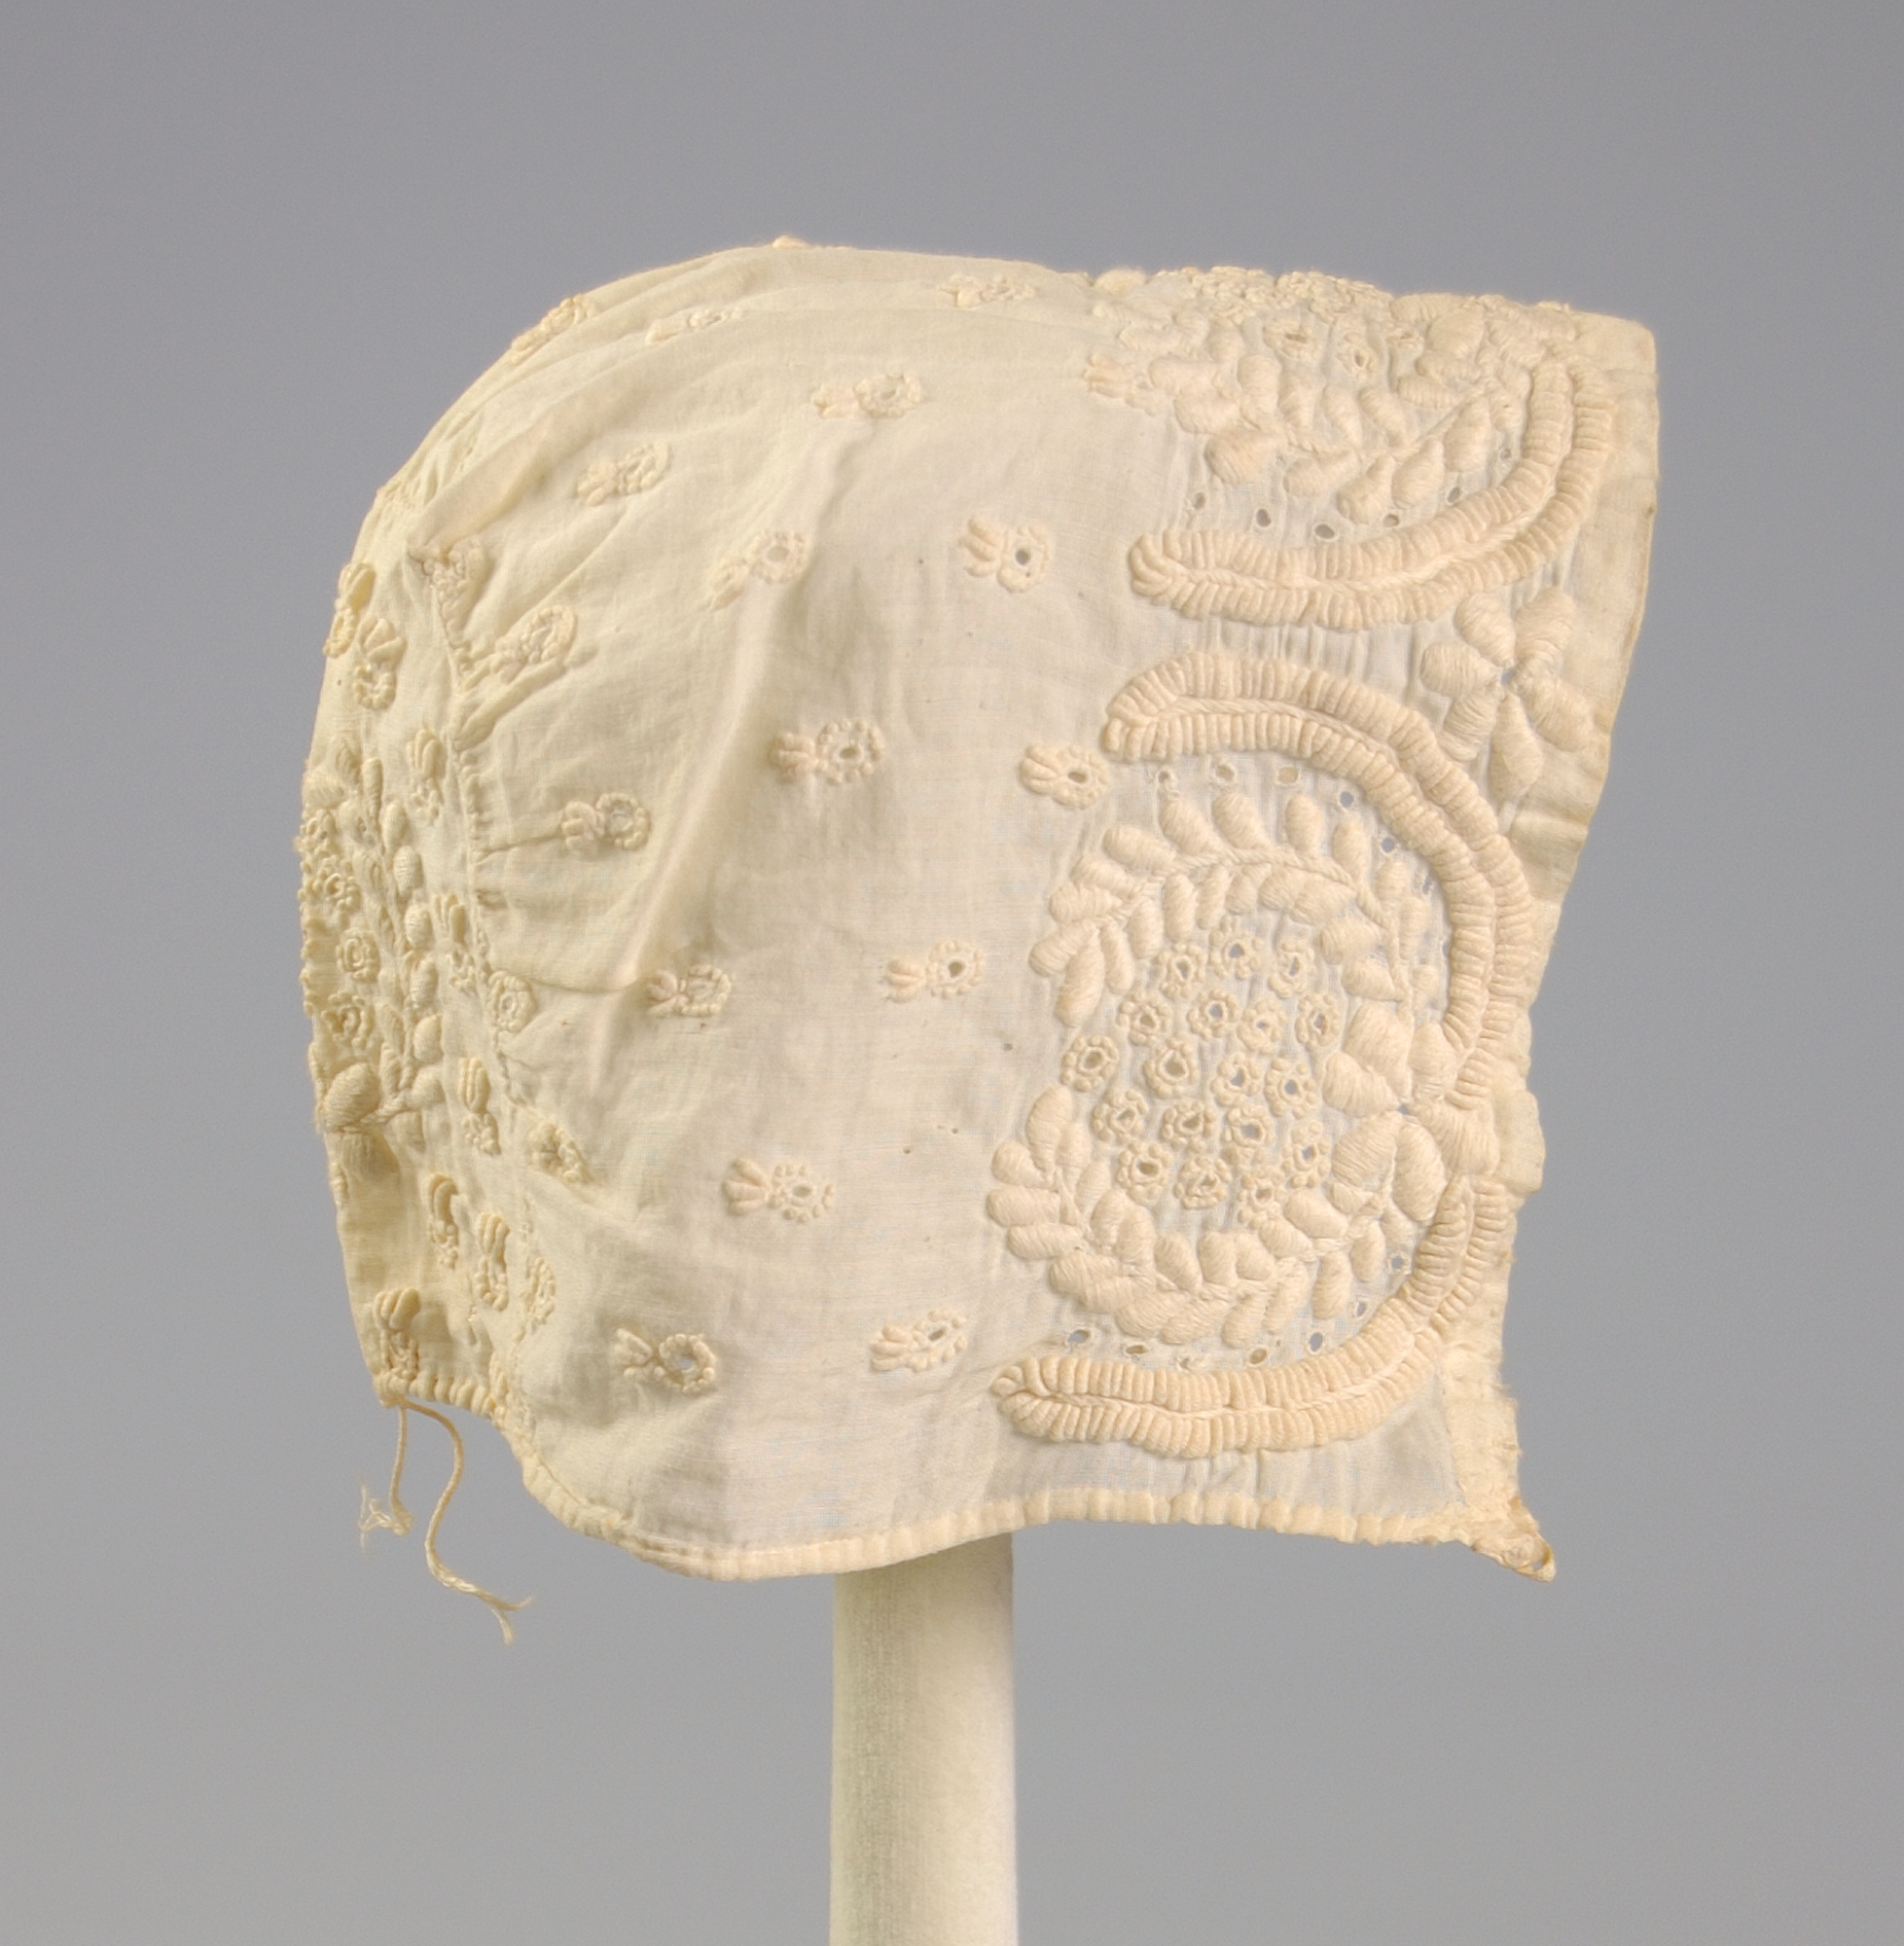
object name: cap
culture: american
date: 1850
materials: linen